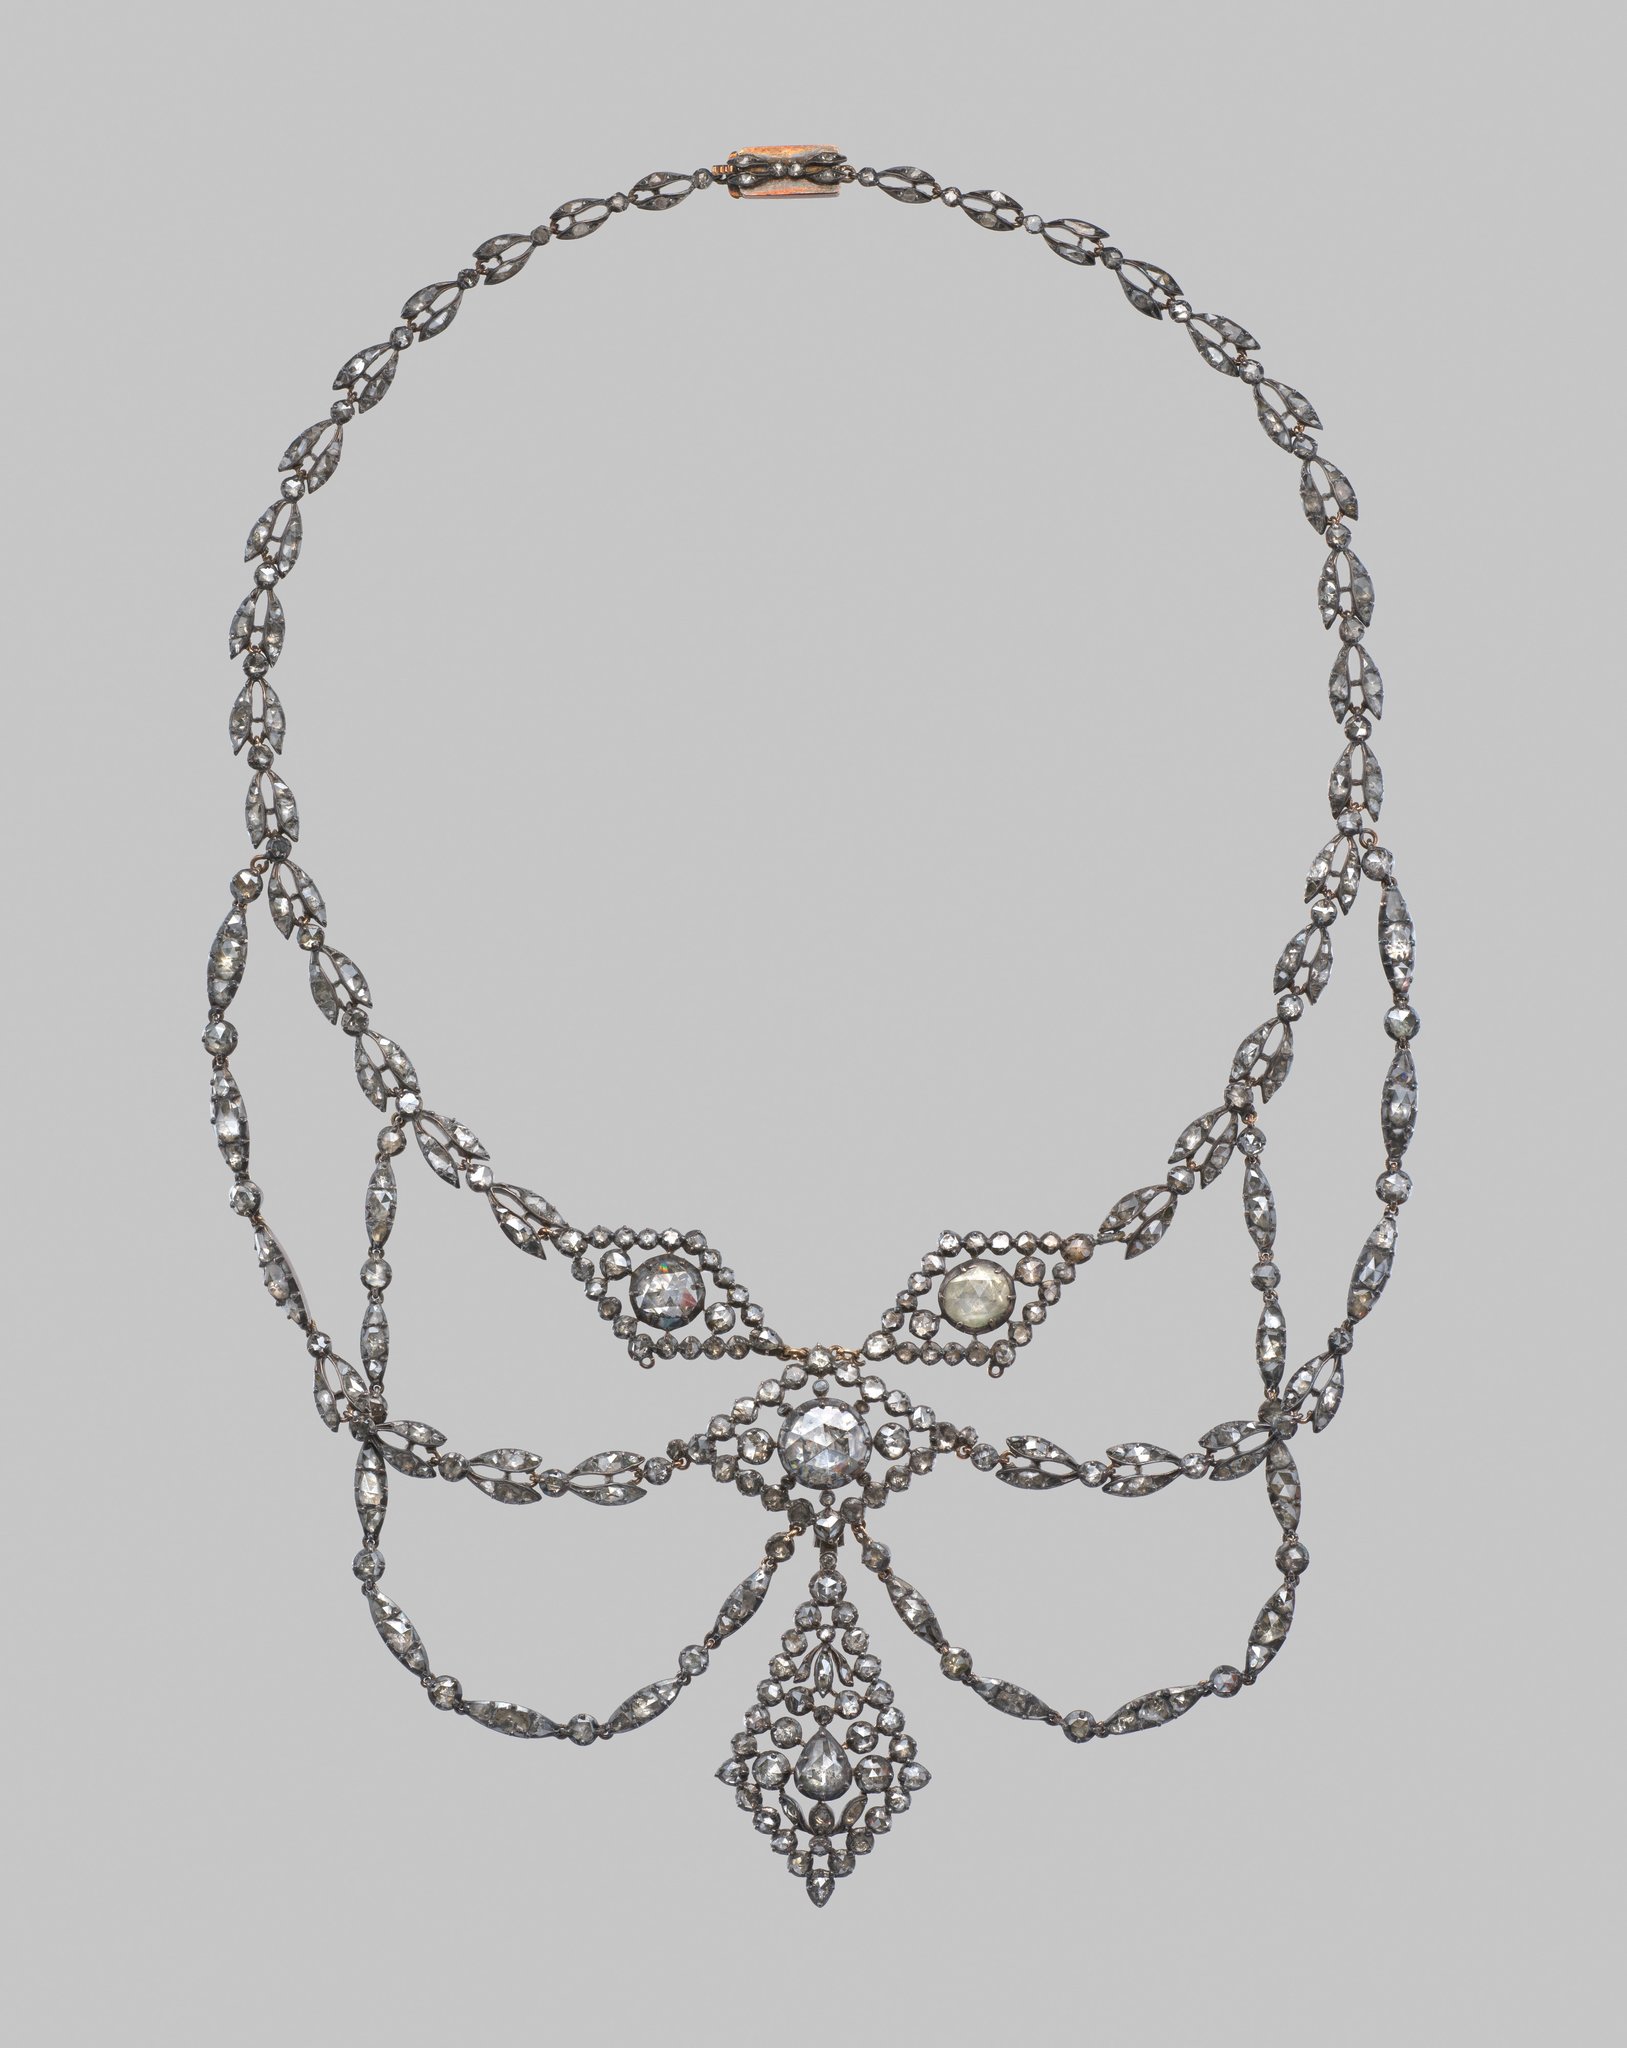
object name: necklace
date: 1701-1800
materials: diamond, gold, silver